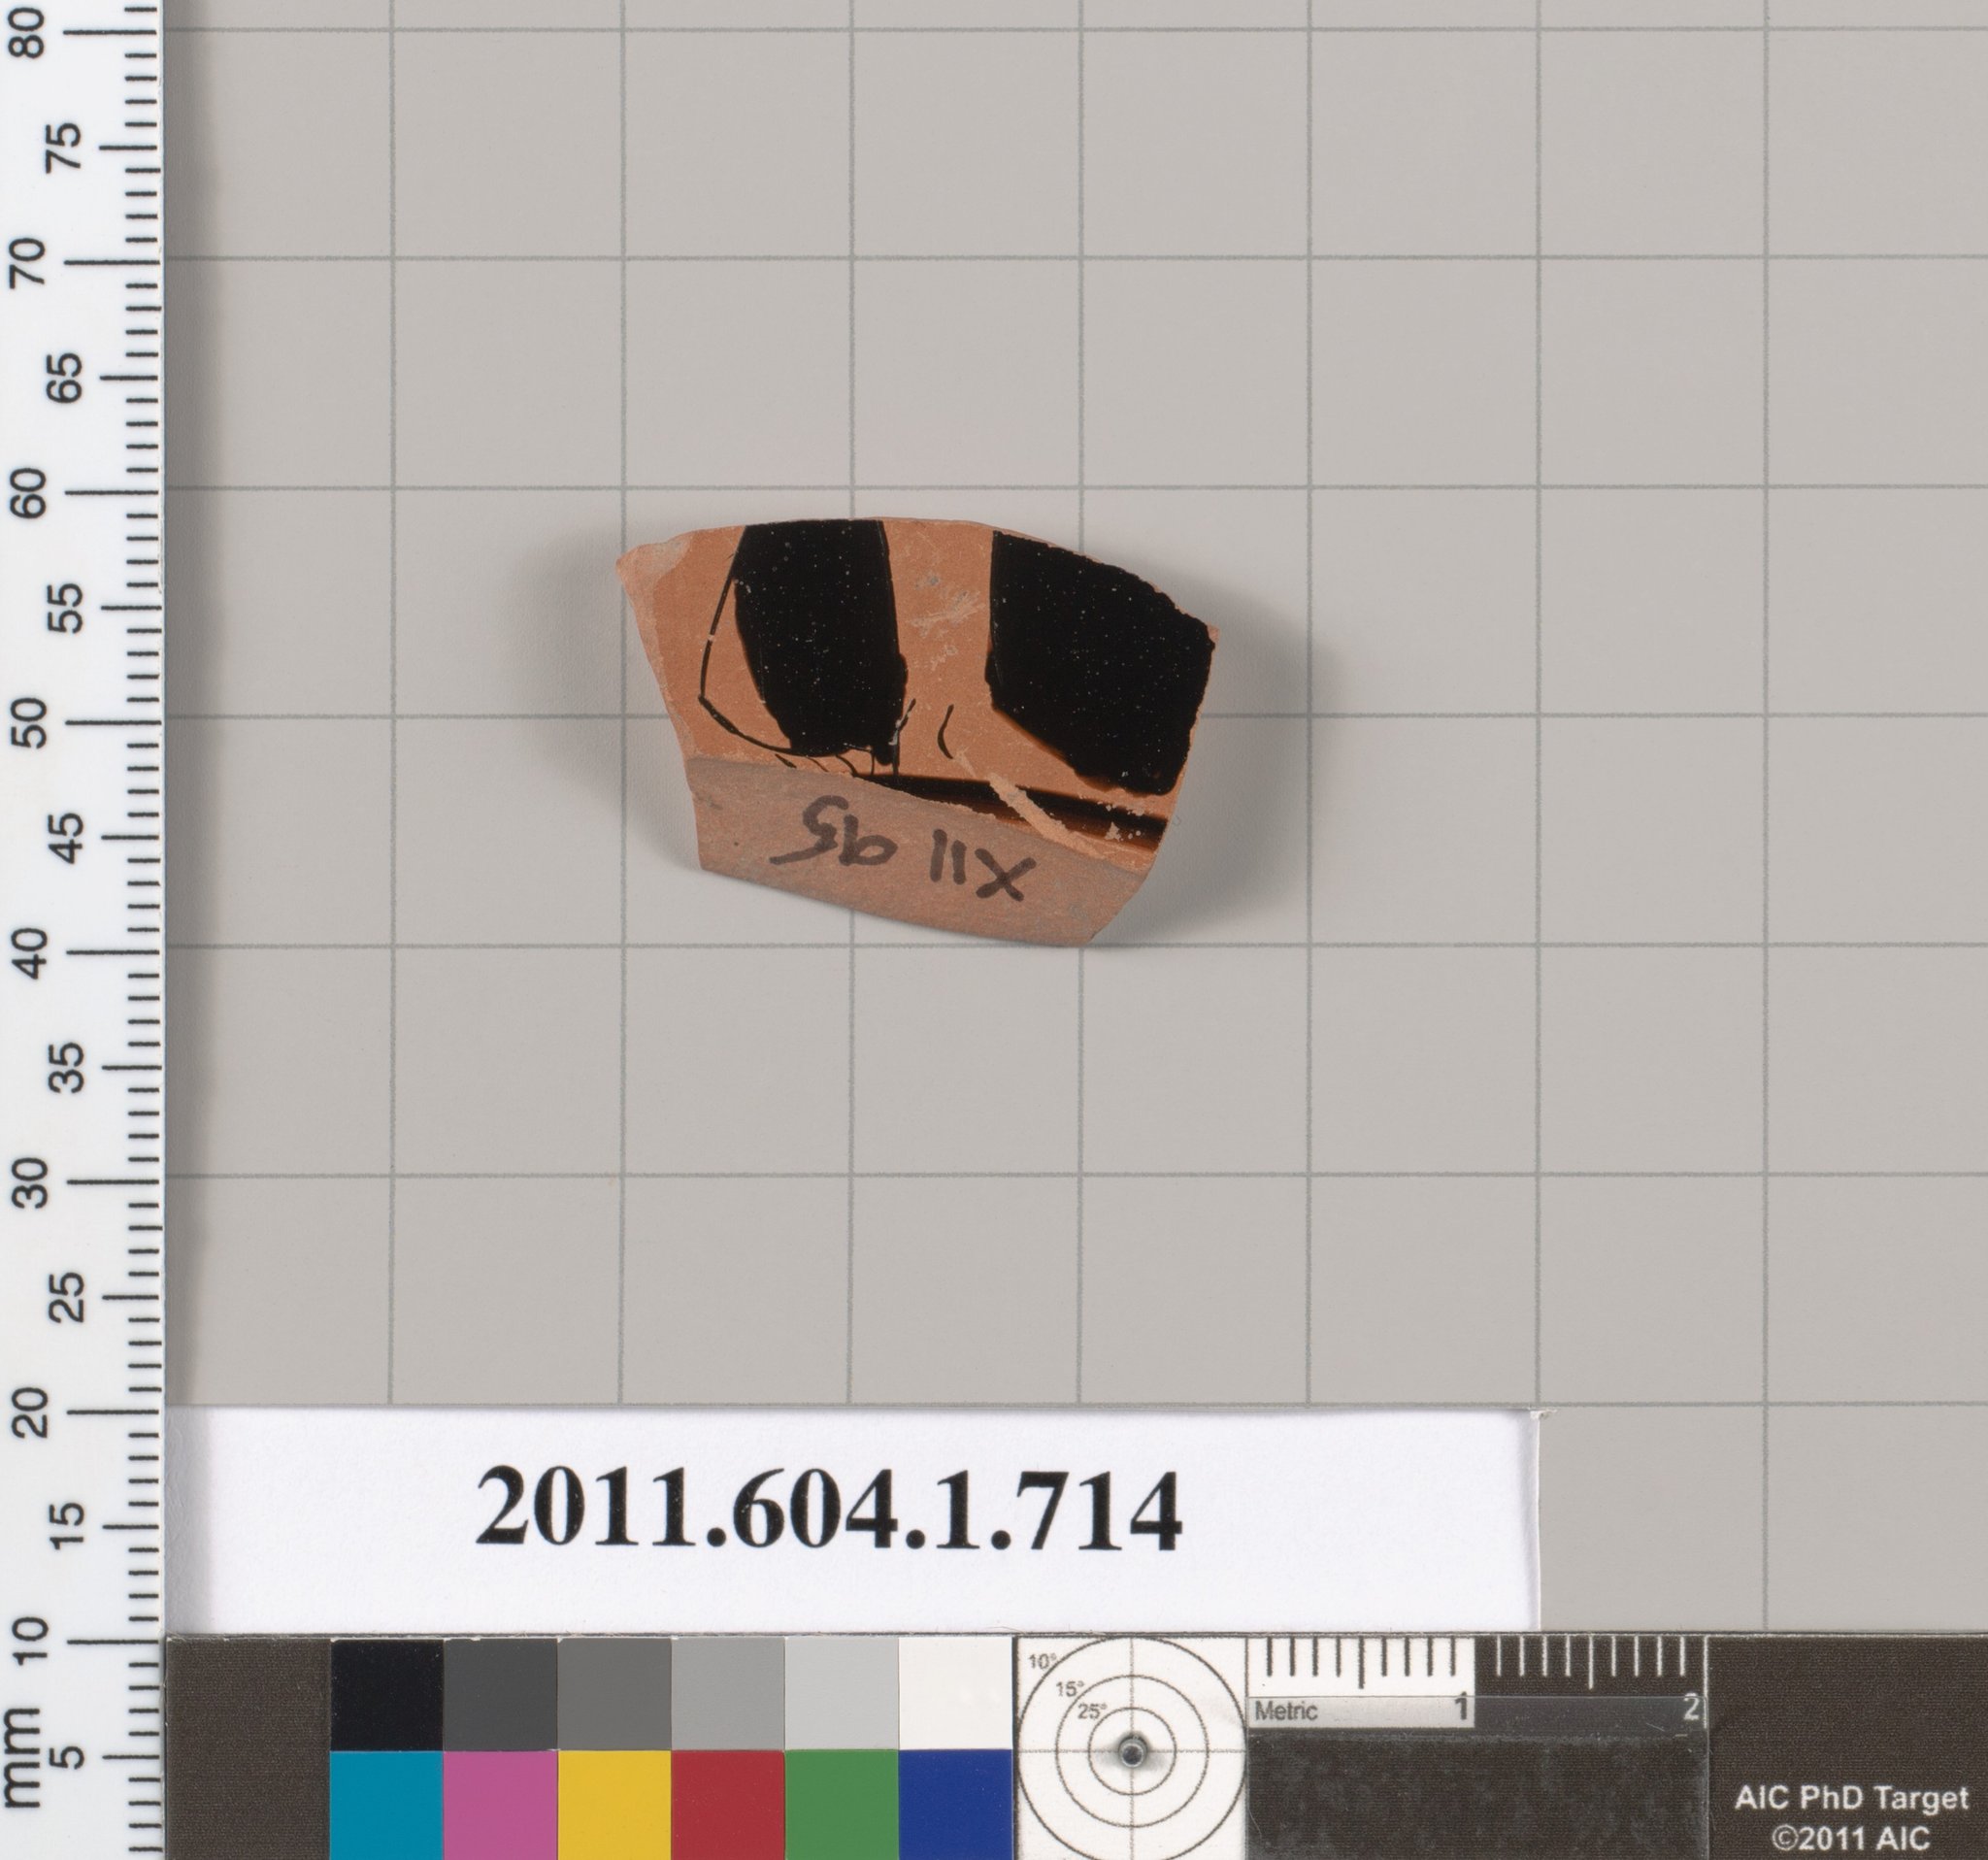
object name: kylix fragment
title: Terracotta fragment of a kylix (drinking cup)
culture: greek, attic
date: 475-451 BCE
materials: terracotta